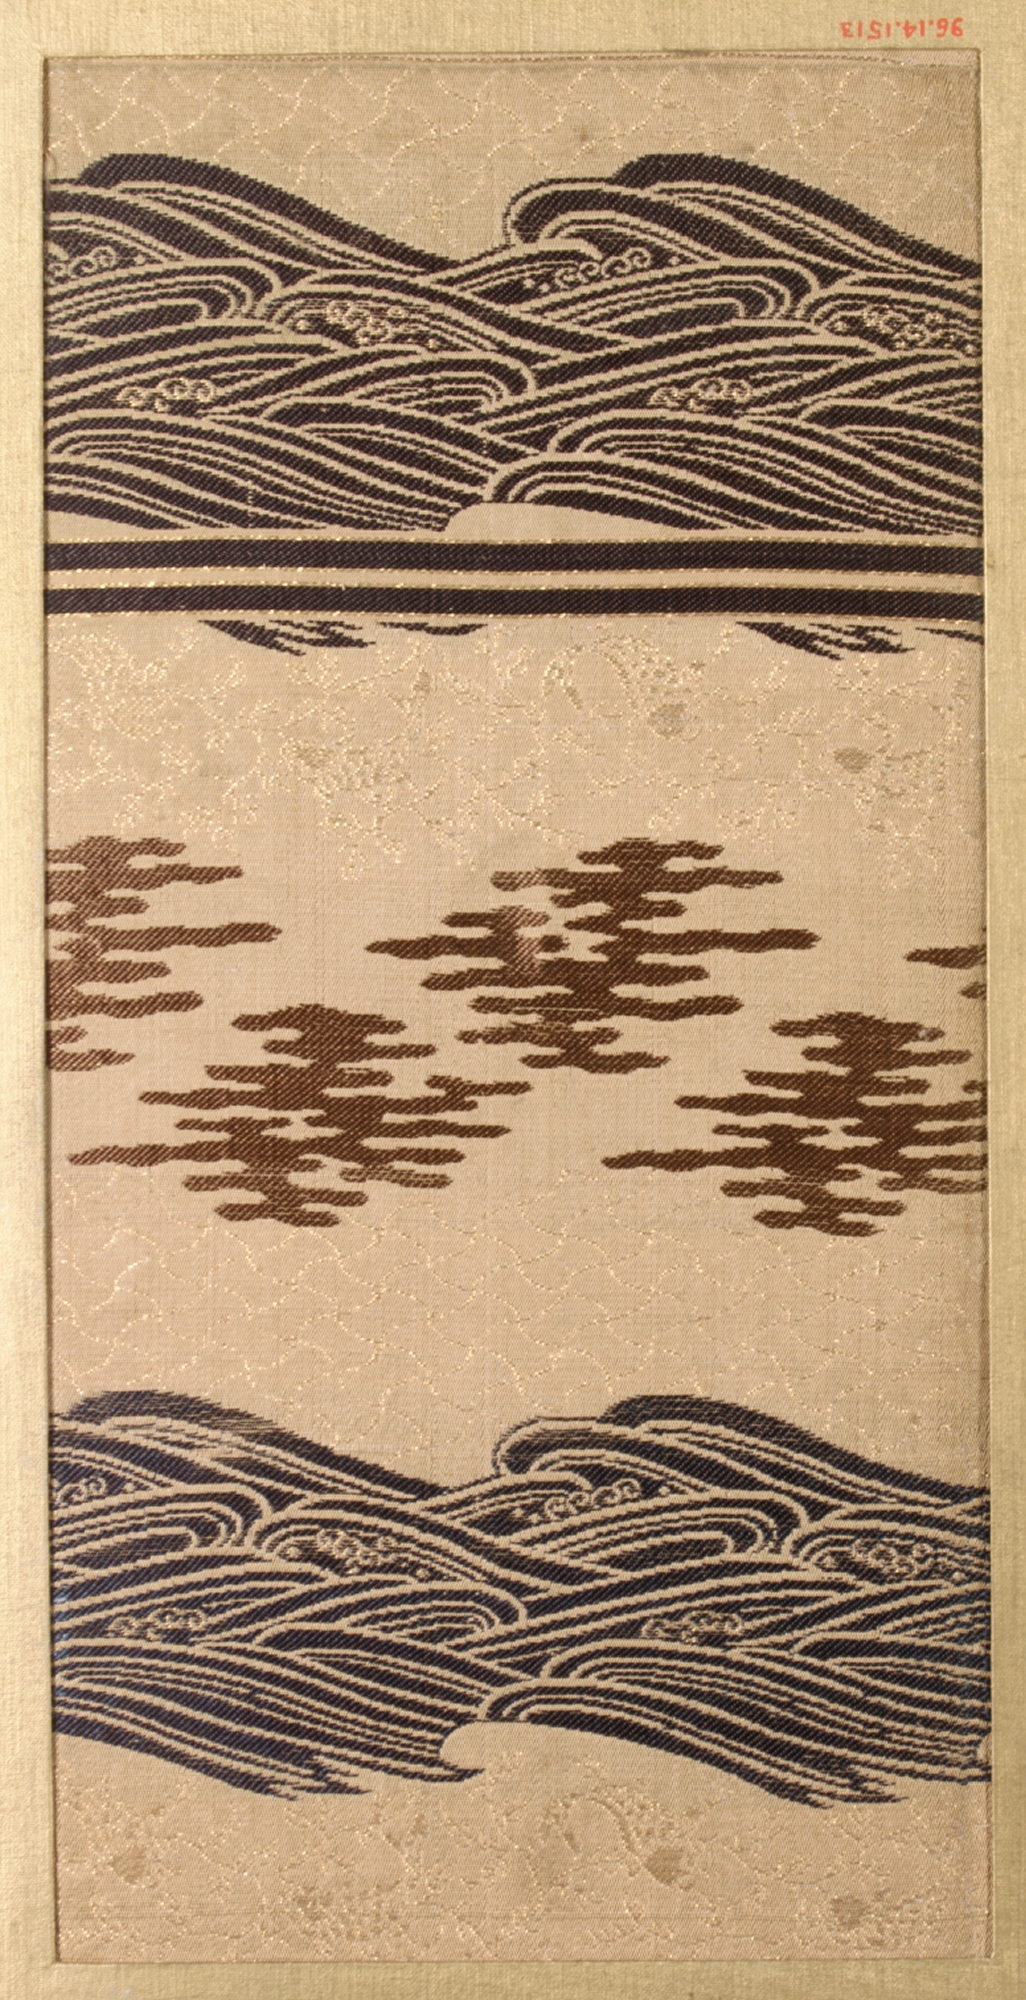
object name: piece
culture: japanese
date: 1701-1900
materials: silk